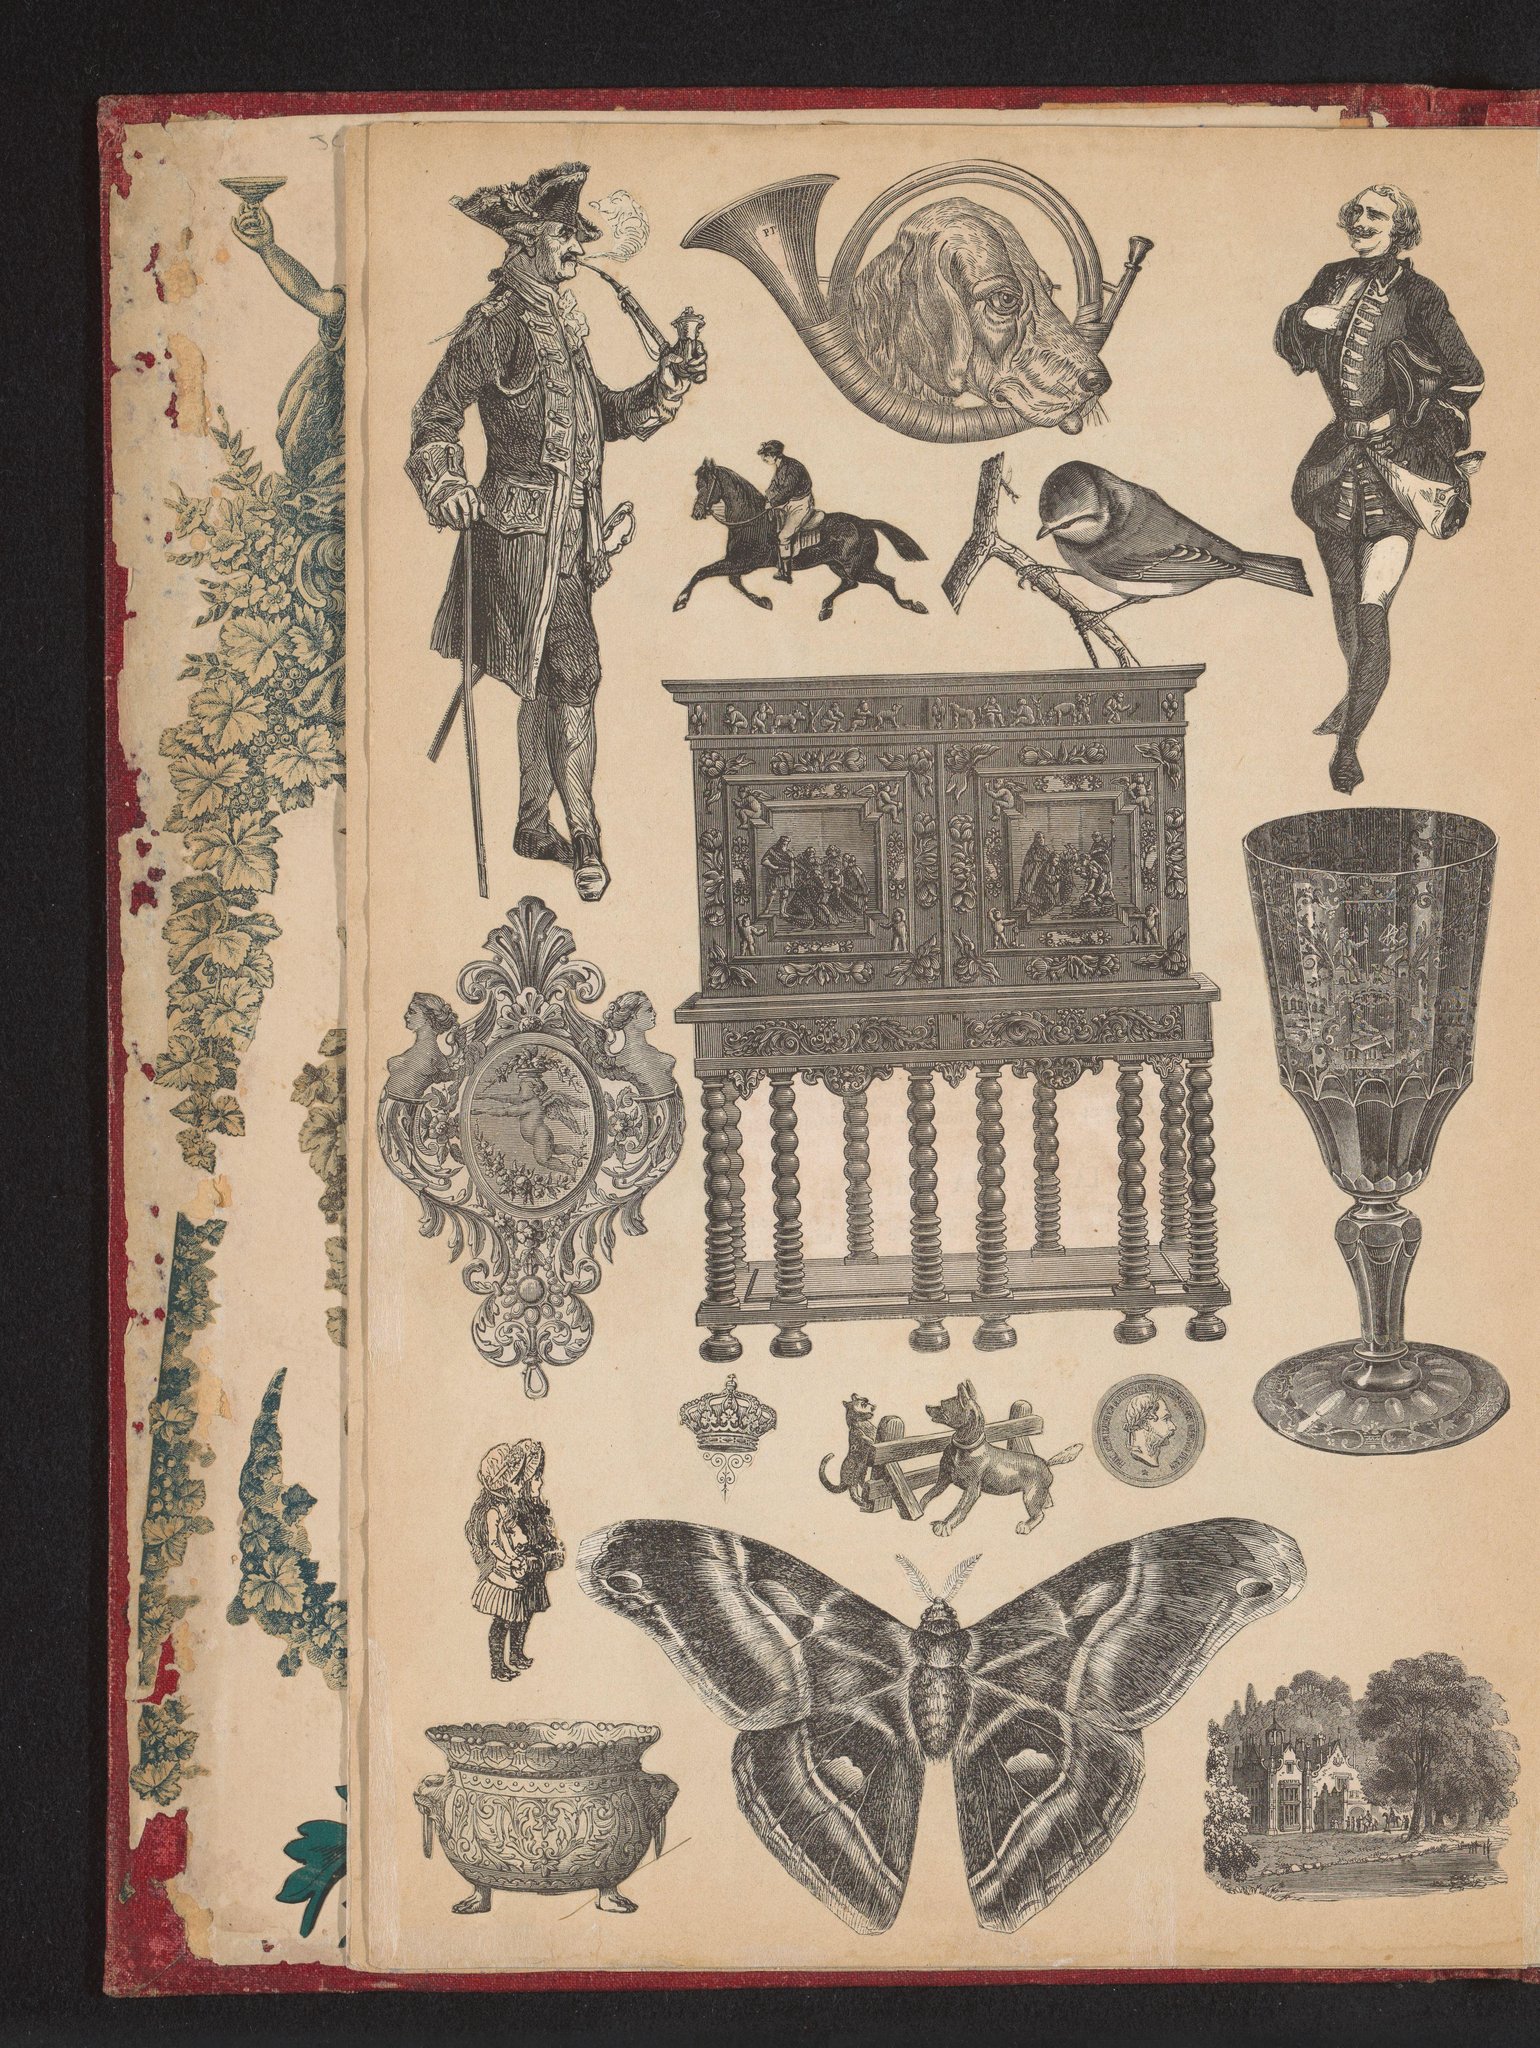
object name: print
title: Collage van uitgeknipte prenten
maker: Anonymous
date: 1870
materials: paper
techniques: engraving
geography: paris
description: Collage van uitgeknipte prenten. Onderdeel van een album met 18 bladen, aan beide zijden beplakt met uitgeknipte prenten, vermoedelijk afkomstig uit 19e-eeuwse tijdschiften.